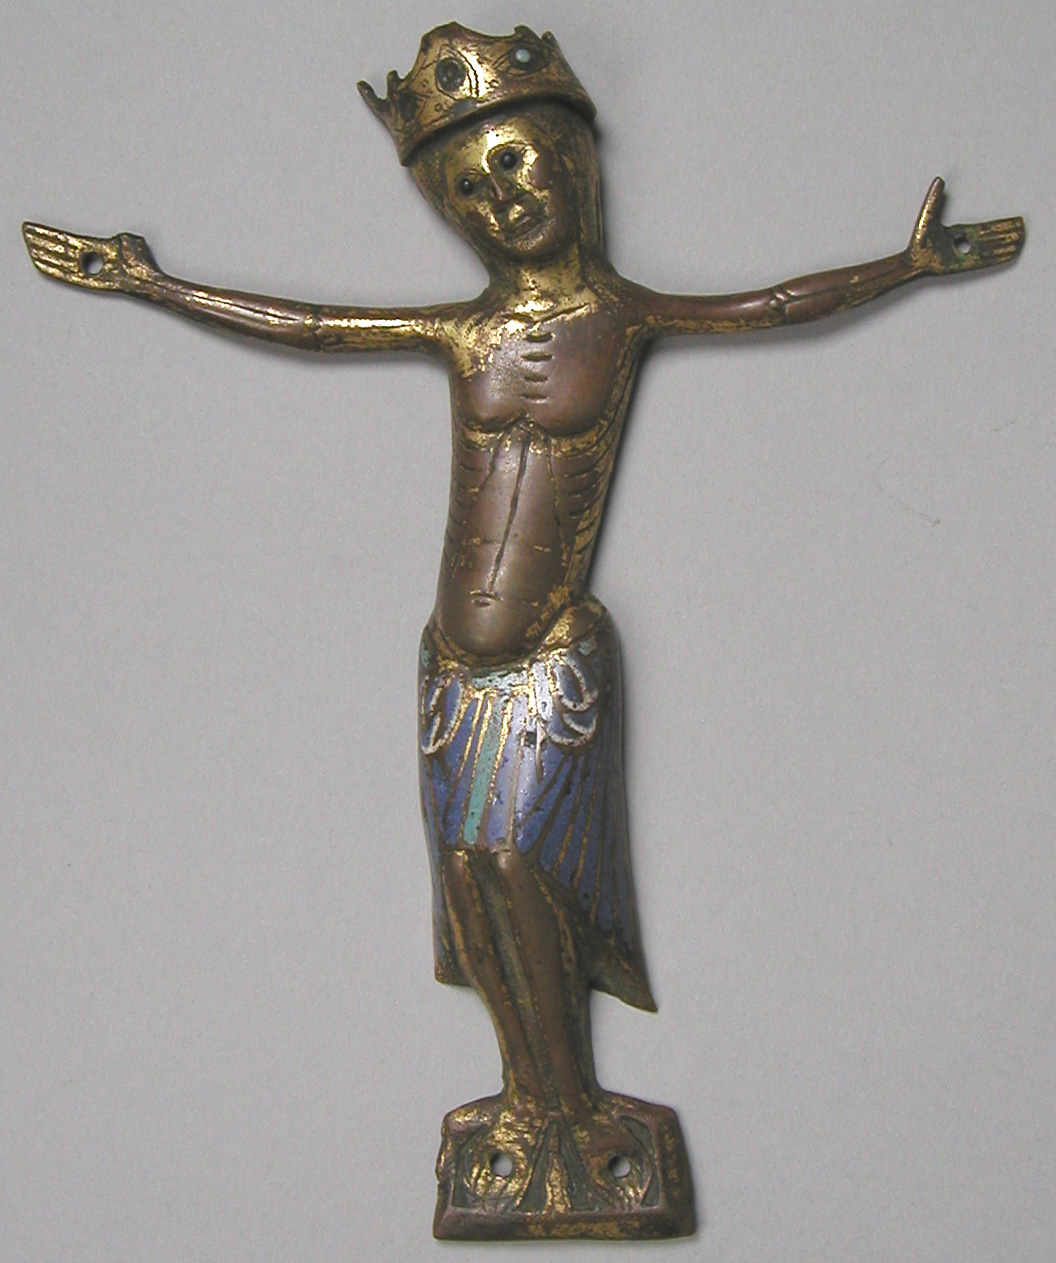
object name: appliqué figure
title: Appliqué Figure of Christ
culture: french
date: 1201-1300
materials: gilt copper, enamel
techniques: enamel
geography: france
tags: christ